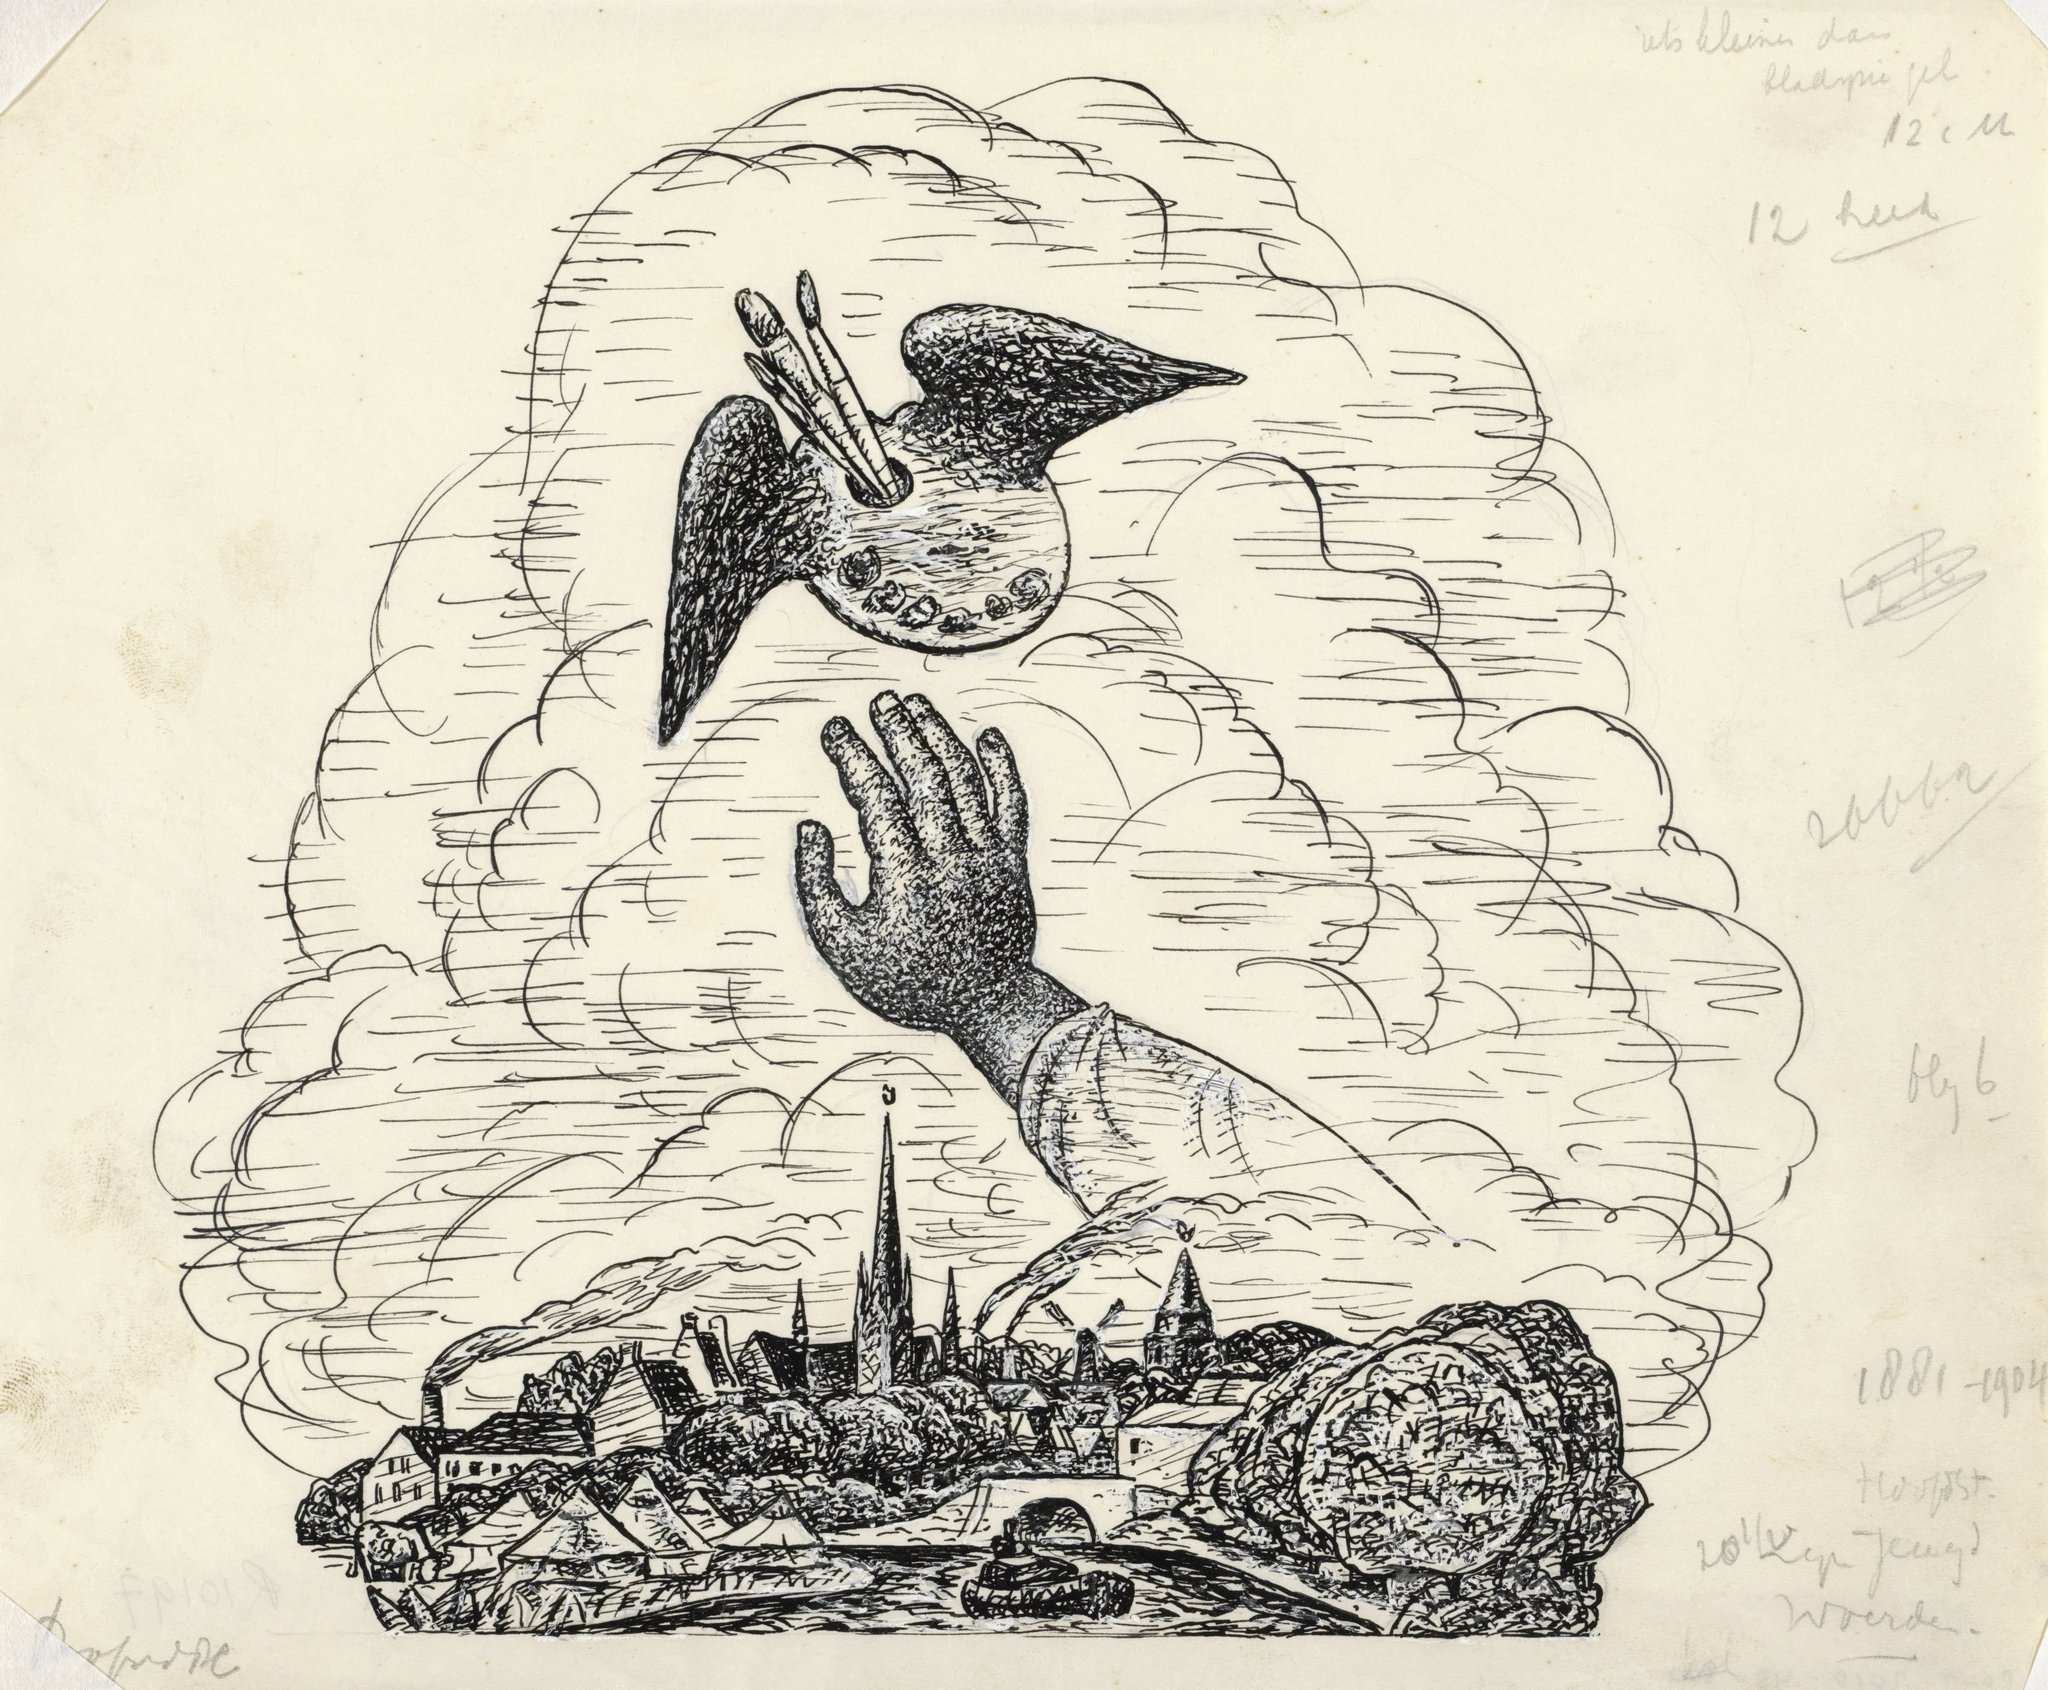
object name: drawing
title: Zonder titel Gezicht op Woerden met hand en vliegend palet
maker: leo gestel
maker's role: draughtsman, print maker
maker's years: 1881-1941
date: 1935-1936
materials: paint, ink, paper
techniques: pen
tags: print maker, draughtsman, leo gestel, city-view in general; 'veduta', palette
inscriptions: inscription: ‘iets kleiner dan / bladspiegel / 12 c M / 12 breed’, inscription: ‘1881-1904 / Hoofdst. / 201/2 Zijn Jeugd / Woerden’, inscription: ‘26662 / blz 6’, inscription: ‘ProfvdPl’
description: De huidige titels zijn door het museum toegekend bij gebrek aan informatie over een originele titel.